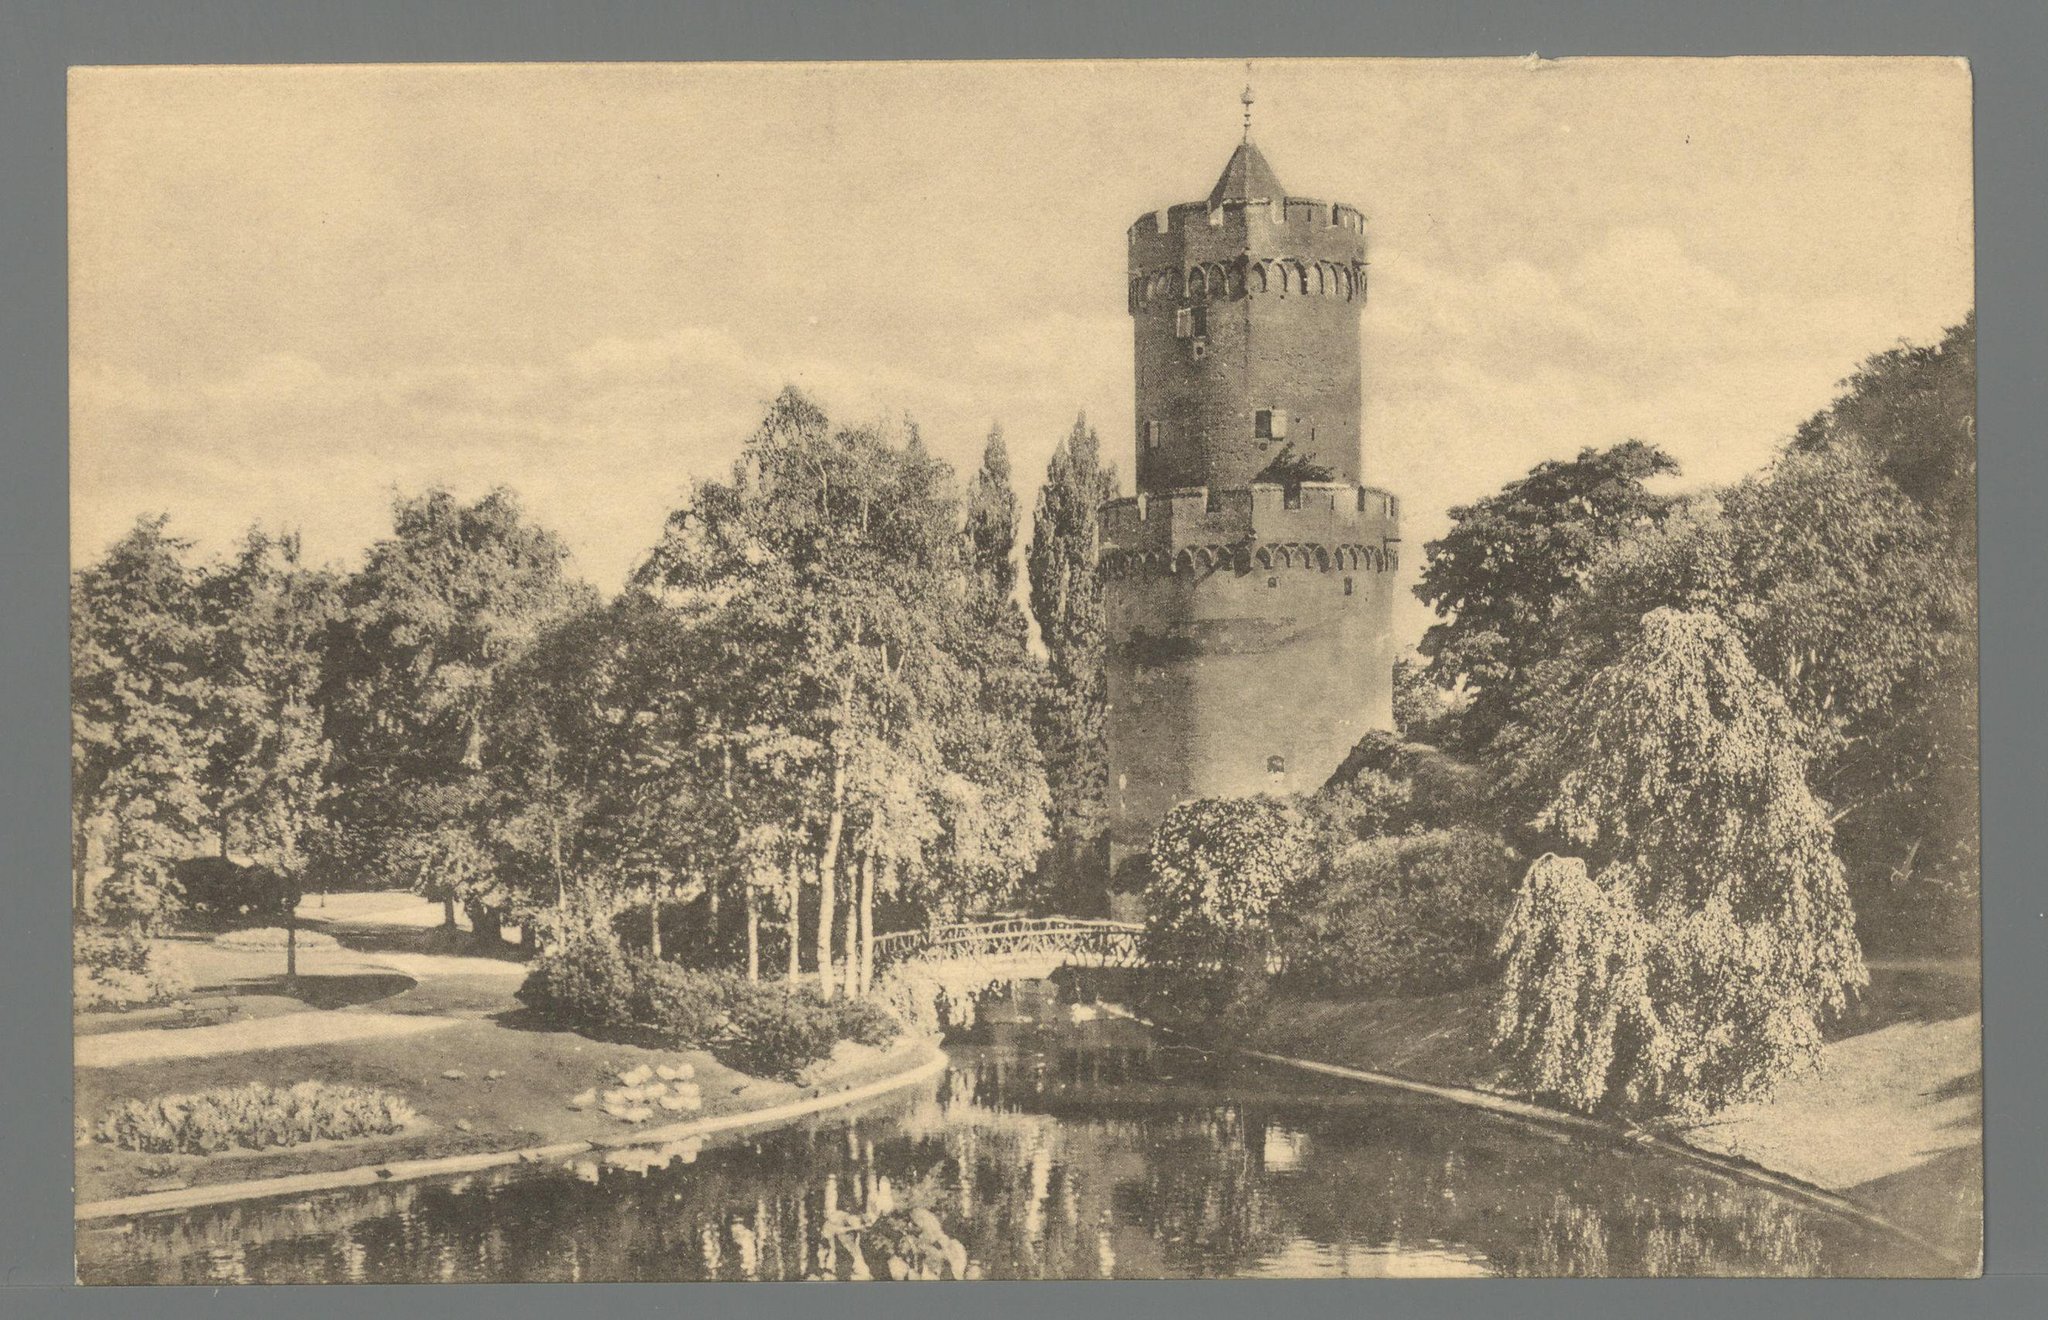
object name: ansichtkaart, prentbriefkaart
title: Nijmegen. Kronenburgerpark, met Kruittoren, één der 16 voormalige verdedigingstorens der stad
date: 1905-1930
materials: cardboard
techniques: photograph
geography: nijmegen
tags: park, towers ~ fortified city